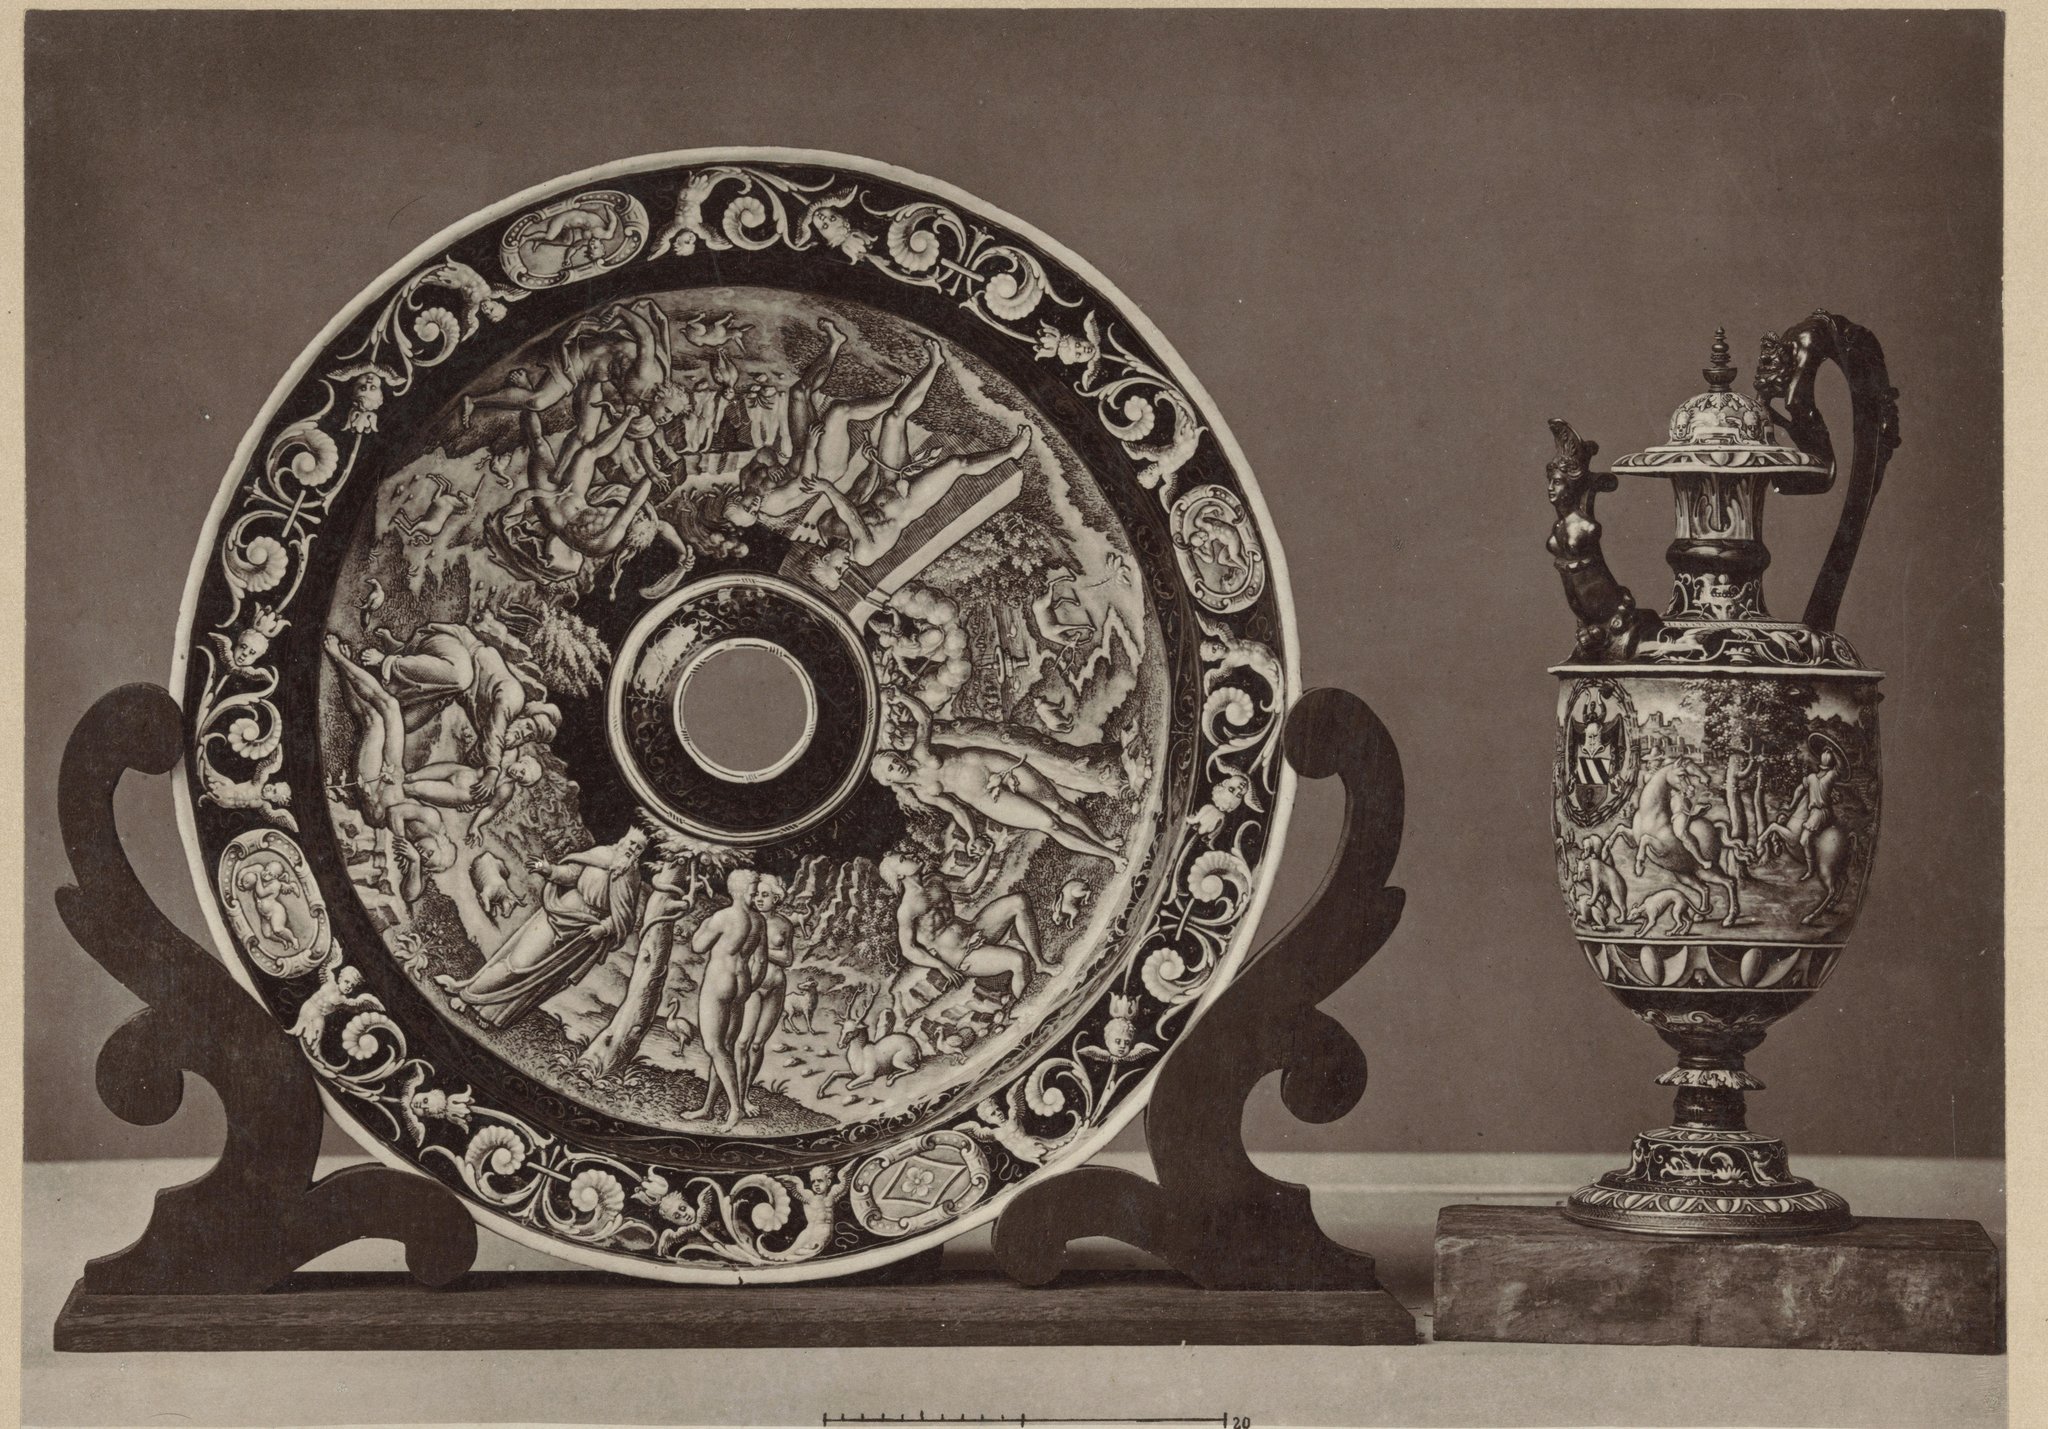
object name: photomechanical print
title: Limoges-Geschirr (Emailie auf Kupfer) von Pierre Reymond, auf Bestellung des Patritzierfamilie Tucher aus Nürnberg gefertigt. 1558-1562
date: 1869-1887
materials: cardboard, paper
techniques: photograph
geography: munich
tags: container of ceramics: jar, jug, pot, vase, dish, plate, saucer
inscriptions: check stamp: ‘Bayerisches National-Museum’, number: ‘No. 5.’